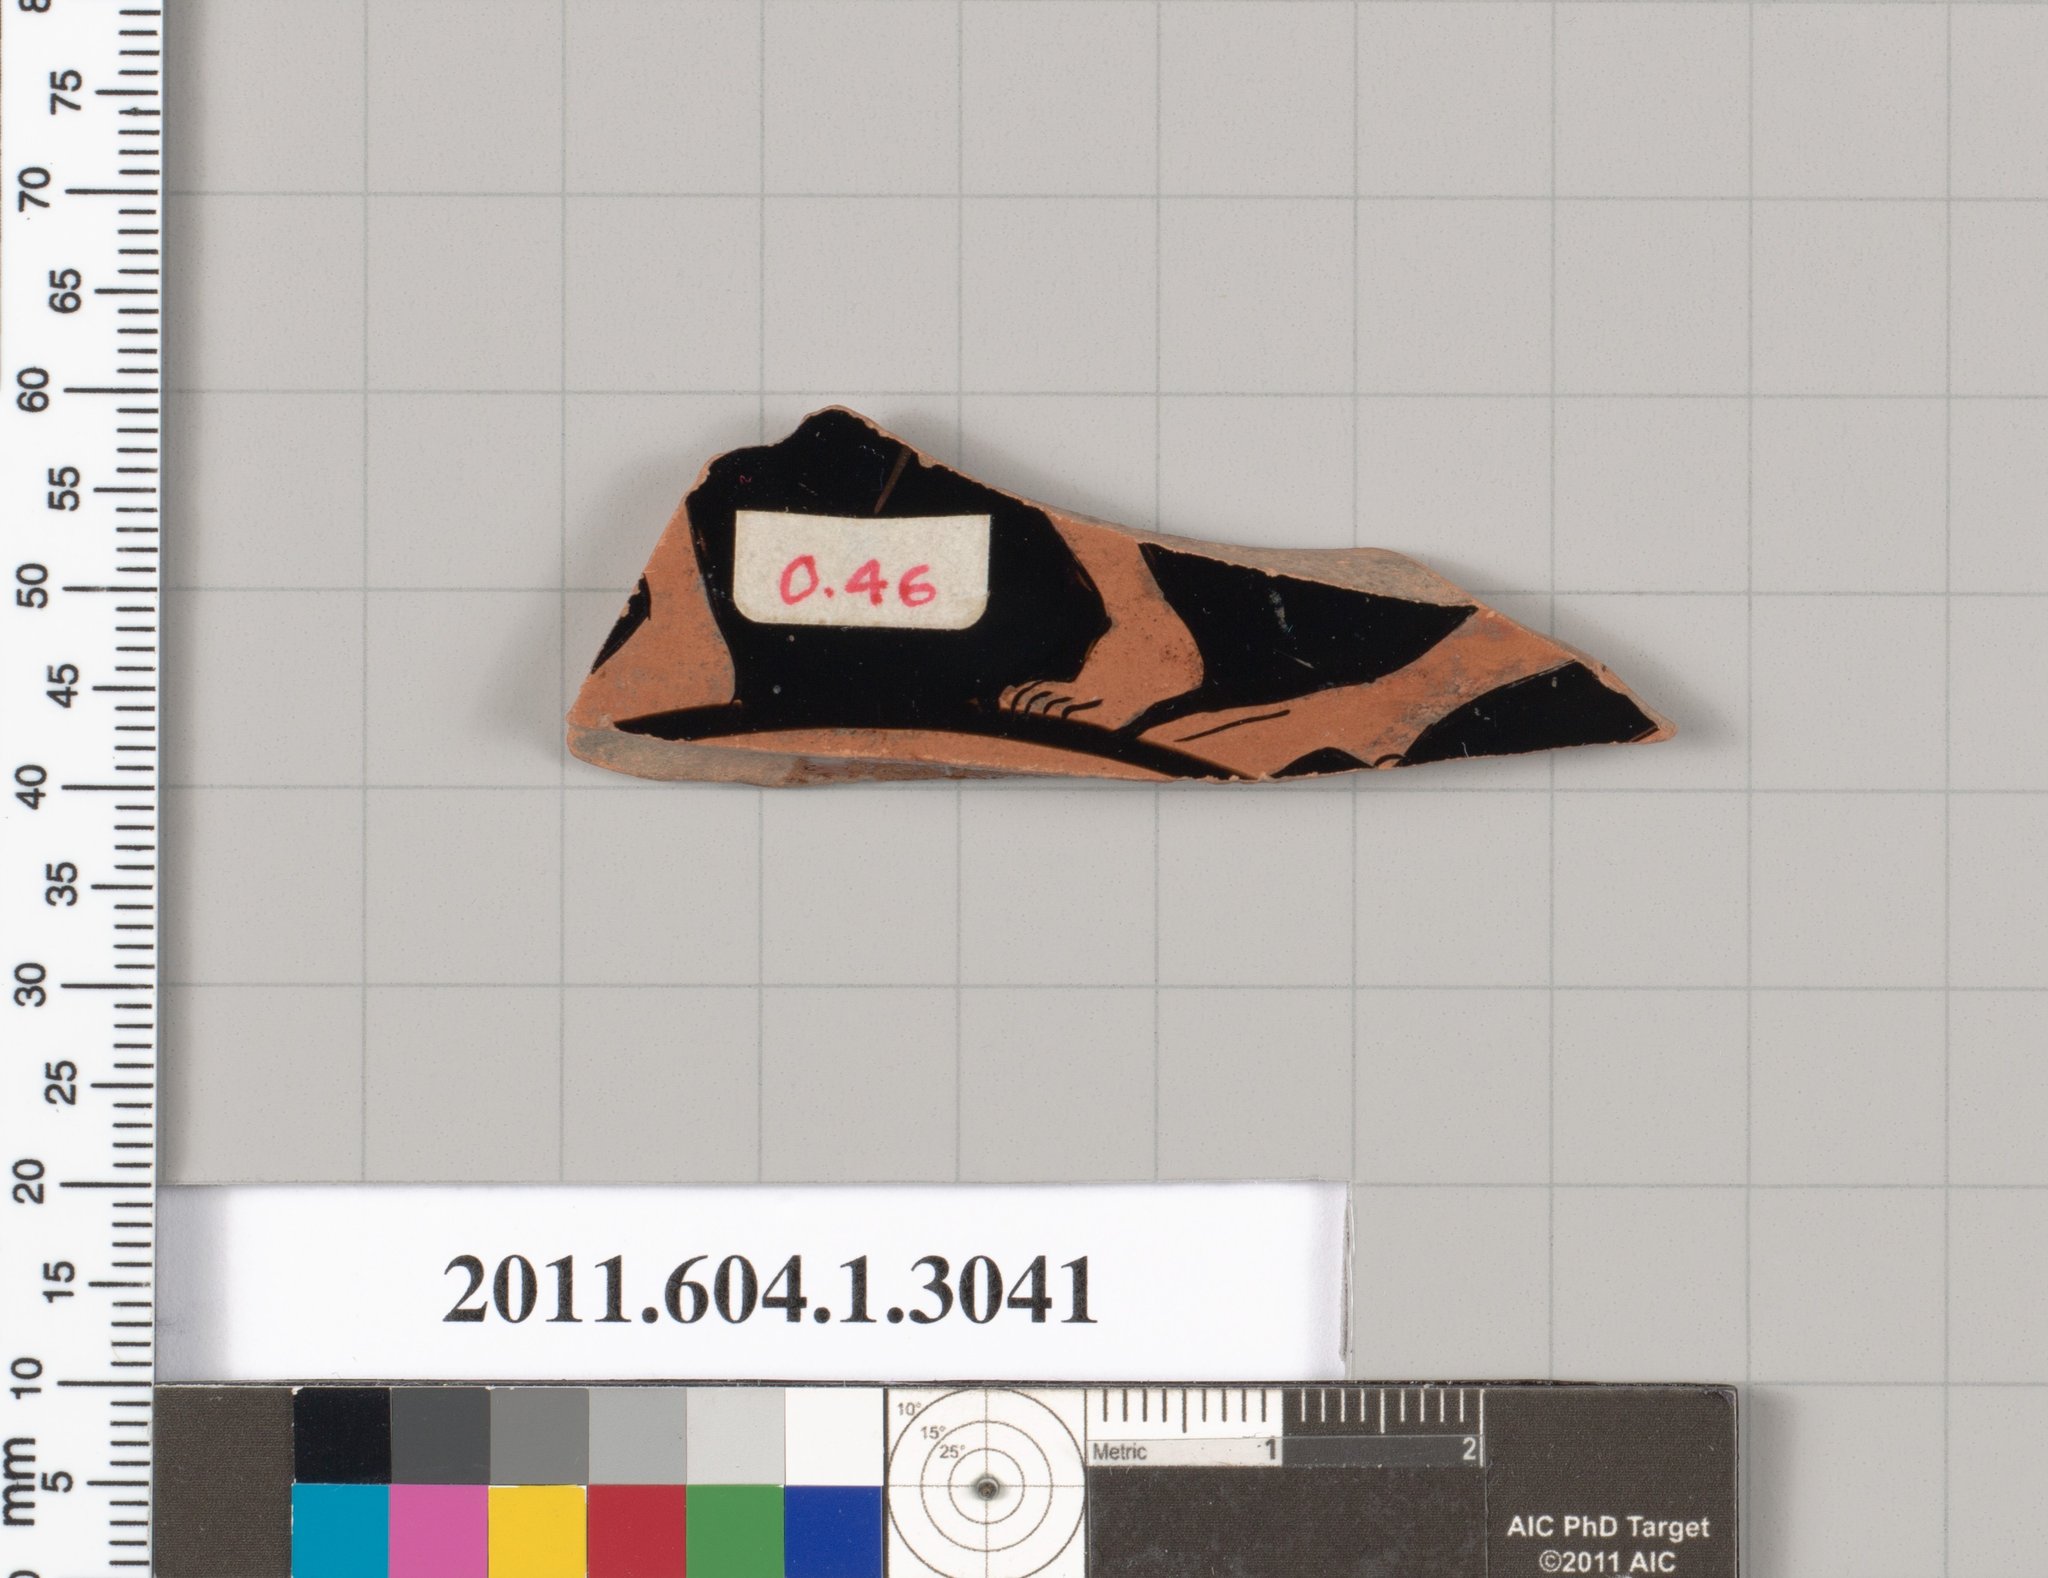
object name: kylix fragment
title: Terracotta fragment of a kylix (drinking cup)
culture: greek, attic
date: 510-490 BCE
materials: terracotta